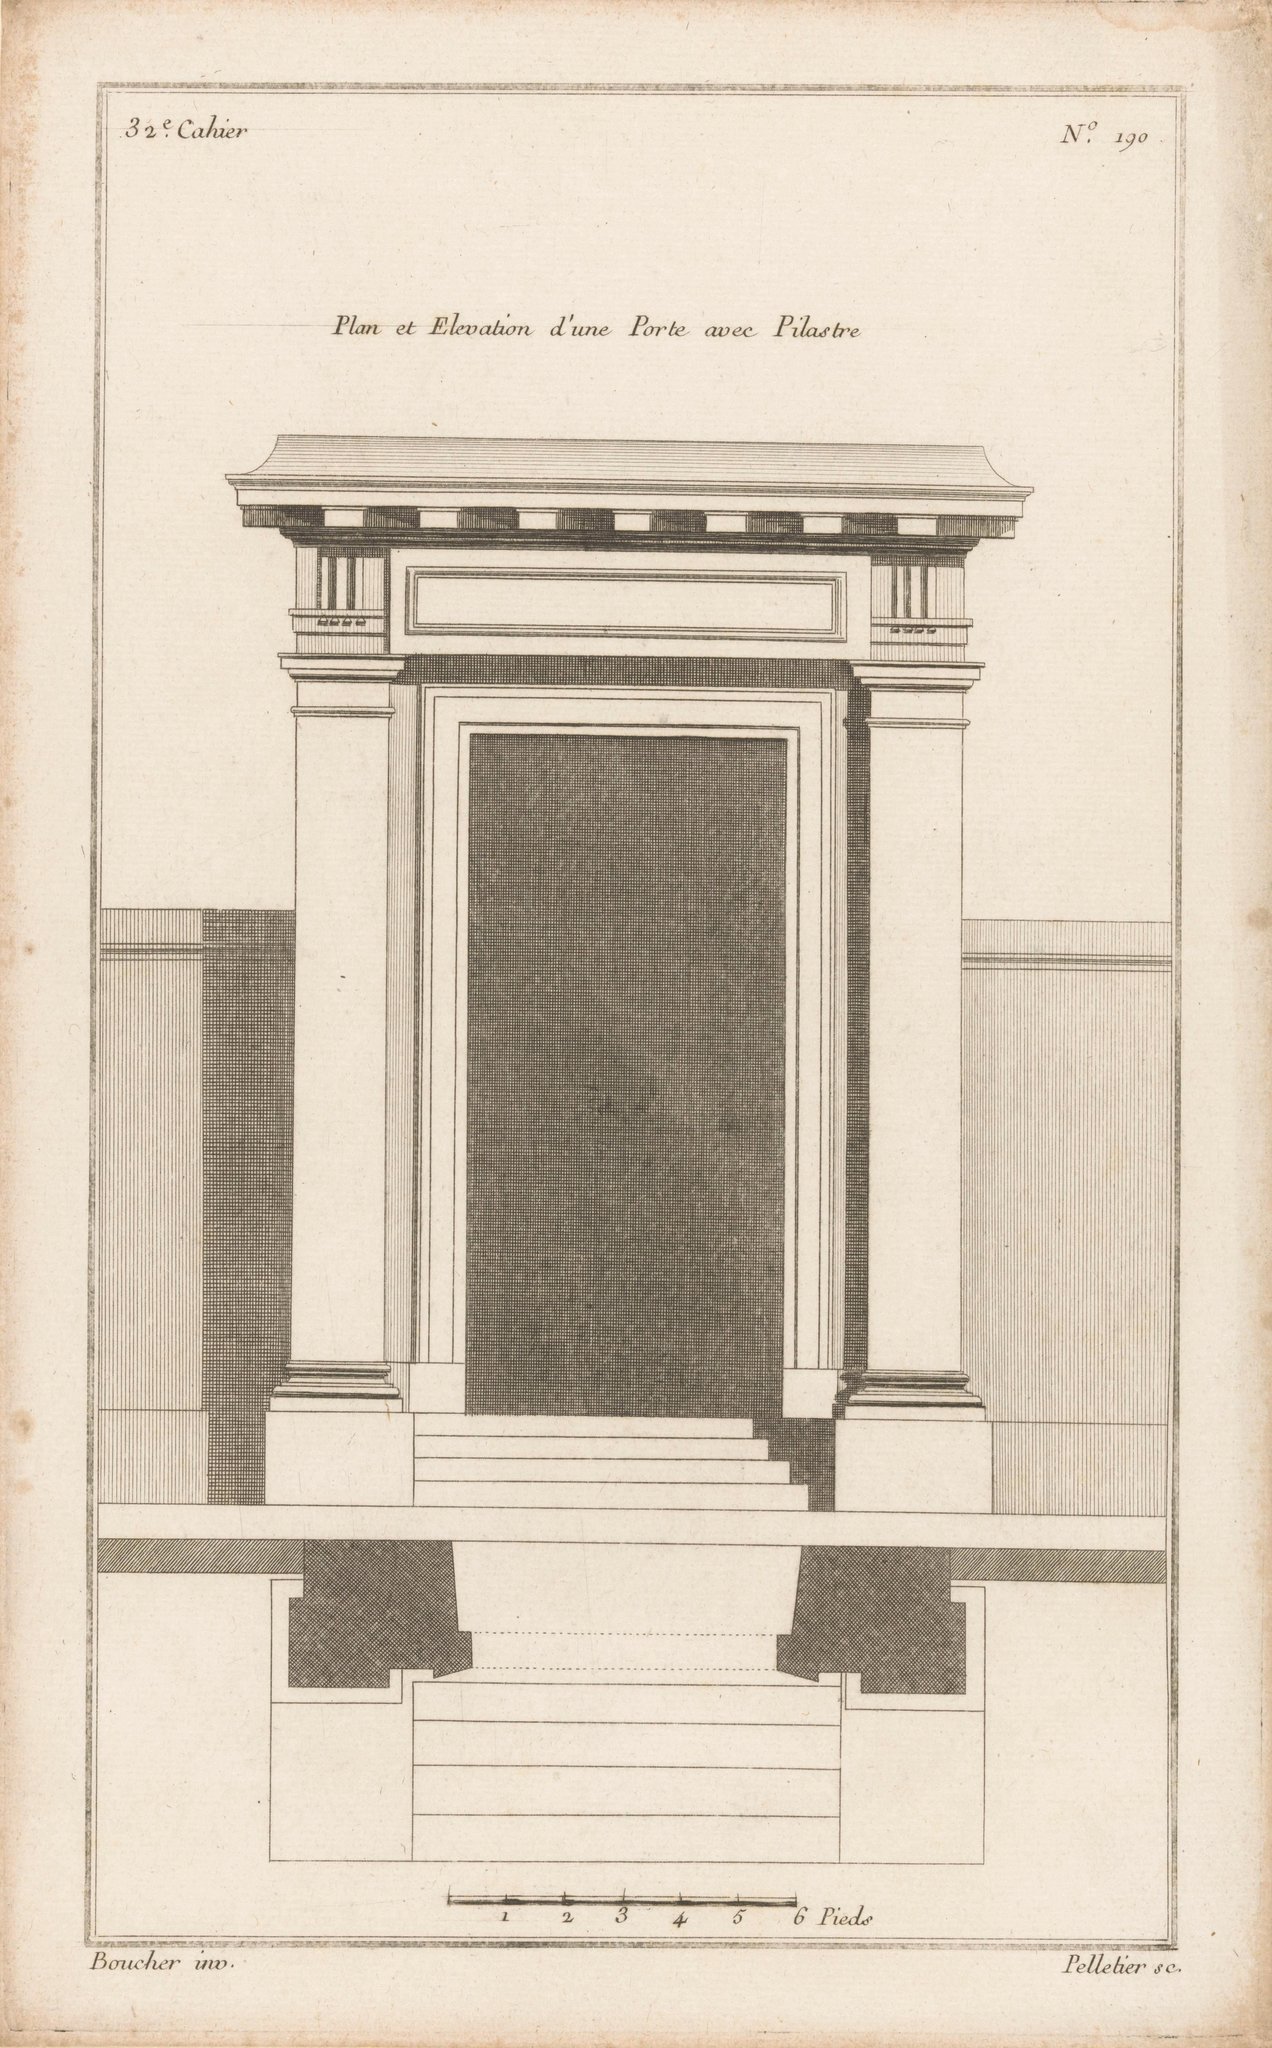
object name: print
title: Plan et elevation d'une Porte avec Pilasters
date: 1772-1779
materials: paper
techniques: engraving, etching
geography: paris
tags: monumental door, porch, 'aediculum', half-column, pilaster ~ architecture, front steps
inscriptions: collector's mark: Lugt 2760, collector's mark: Lugt 2228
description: Voor- en bovenaanzicht van een poort met pilasters en een trappartij. Prentnummer 190.